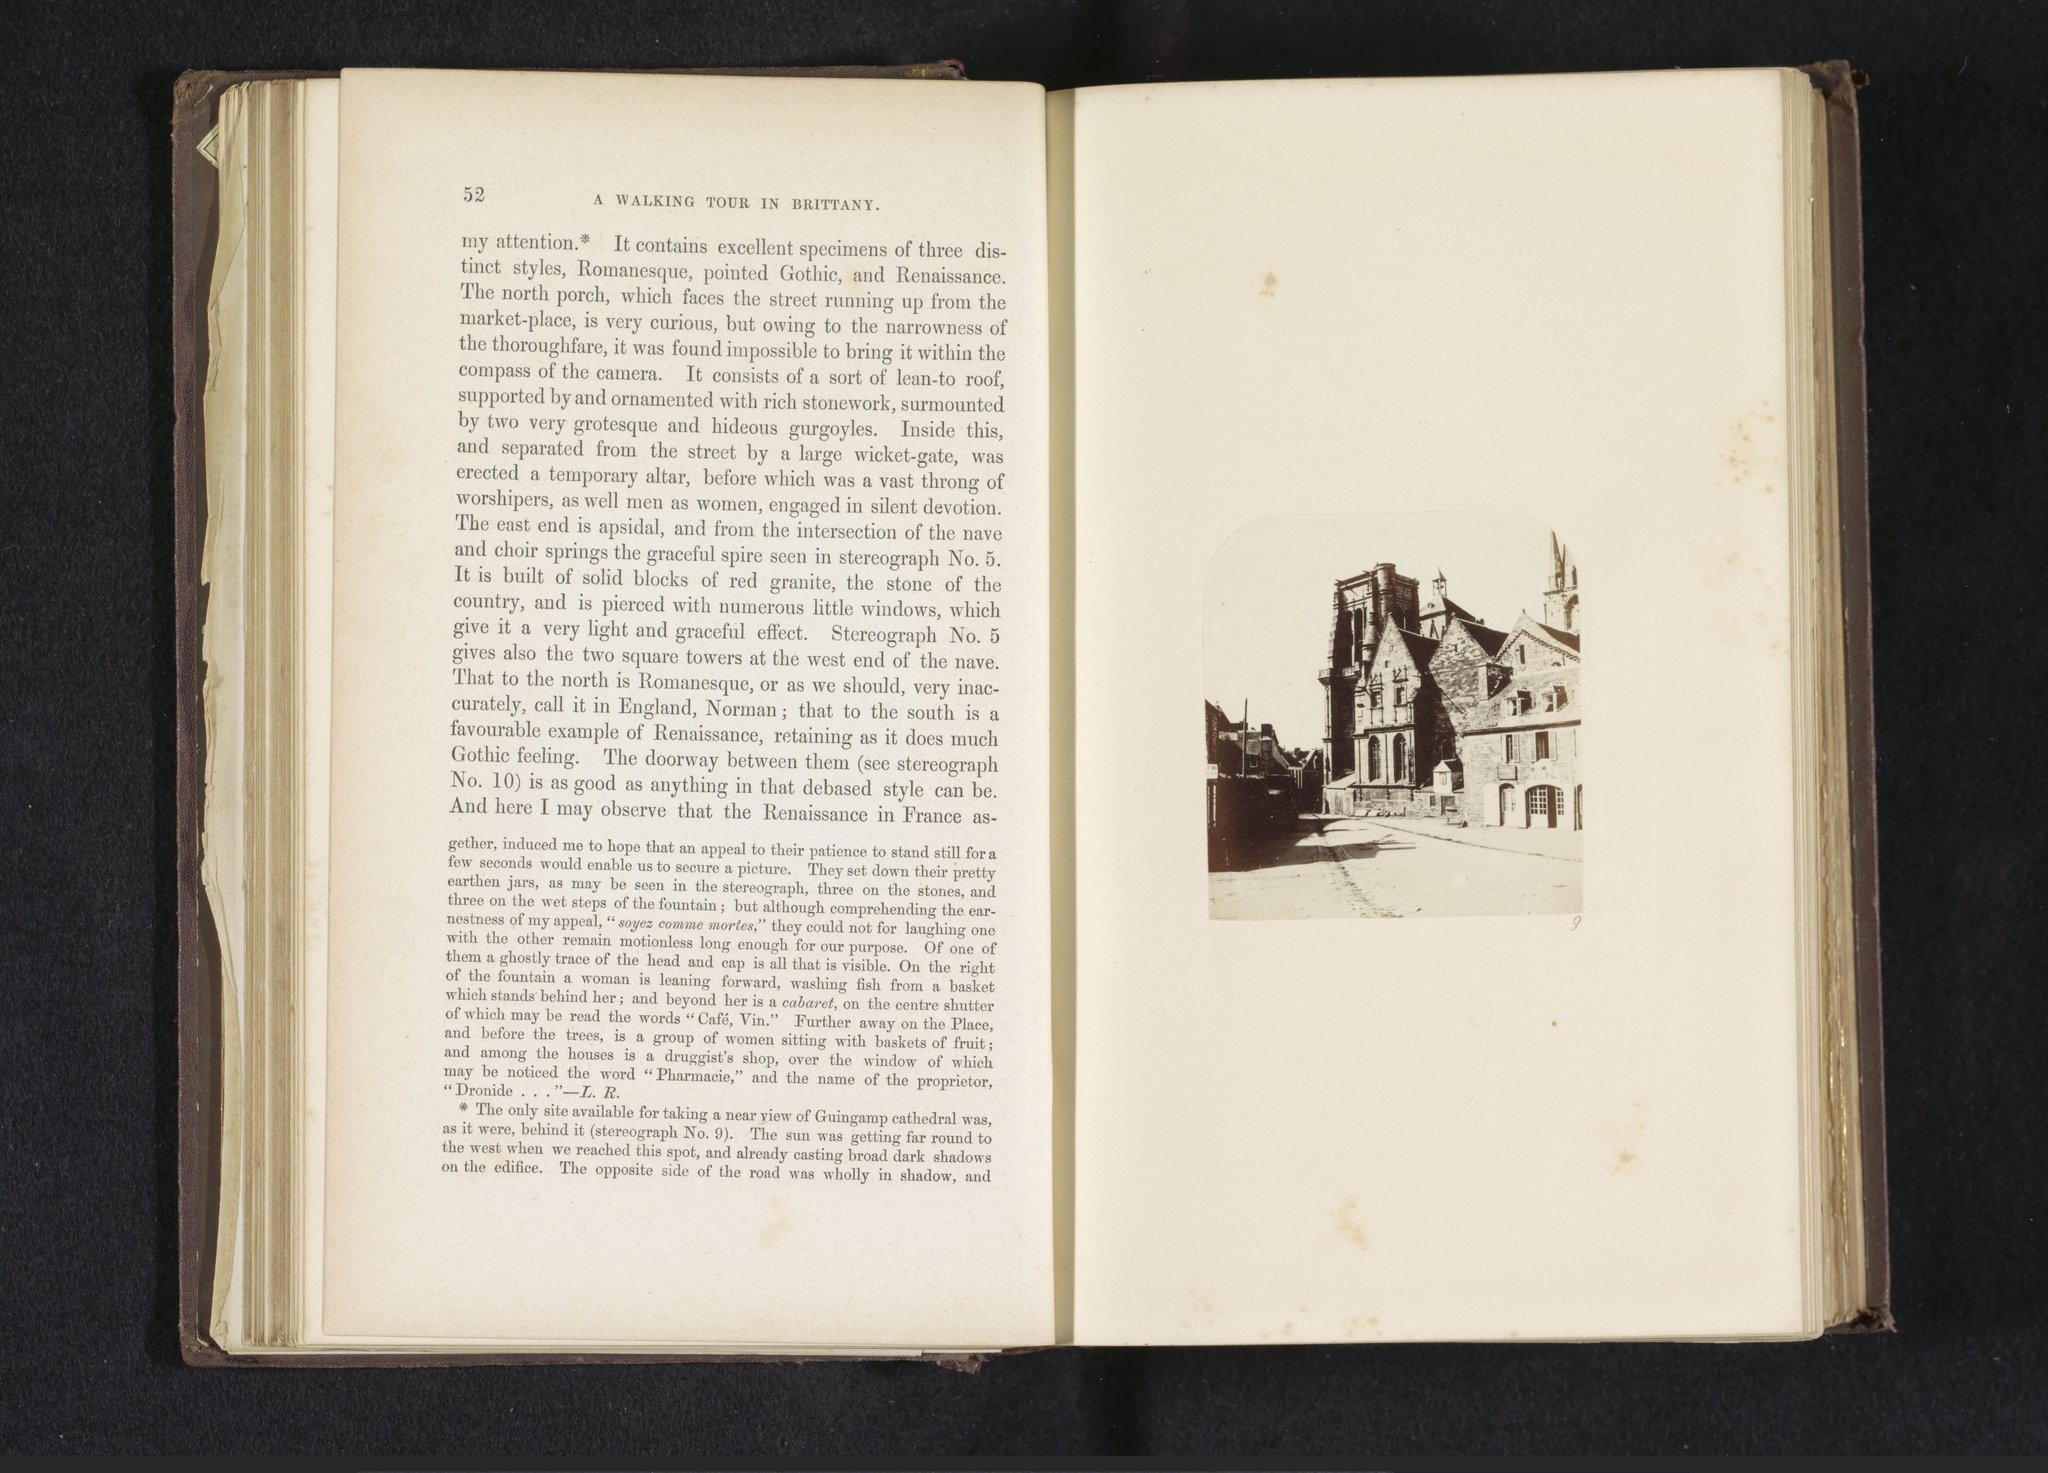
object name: page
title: Zuidwestelijke hoek van de kathedraal van Guincamp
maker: taylor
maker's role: fotograaf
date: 1850-1859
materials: photographic support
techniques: albumen print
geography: guingamp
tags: church (exterior)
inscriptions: number: ‘9’